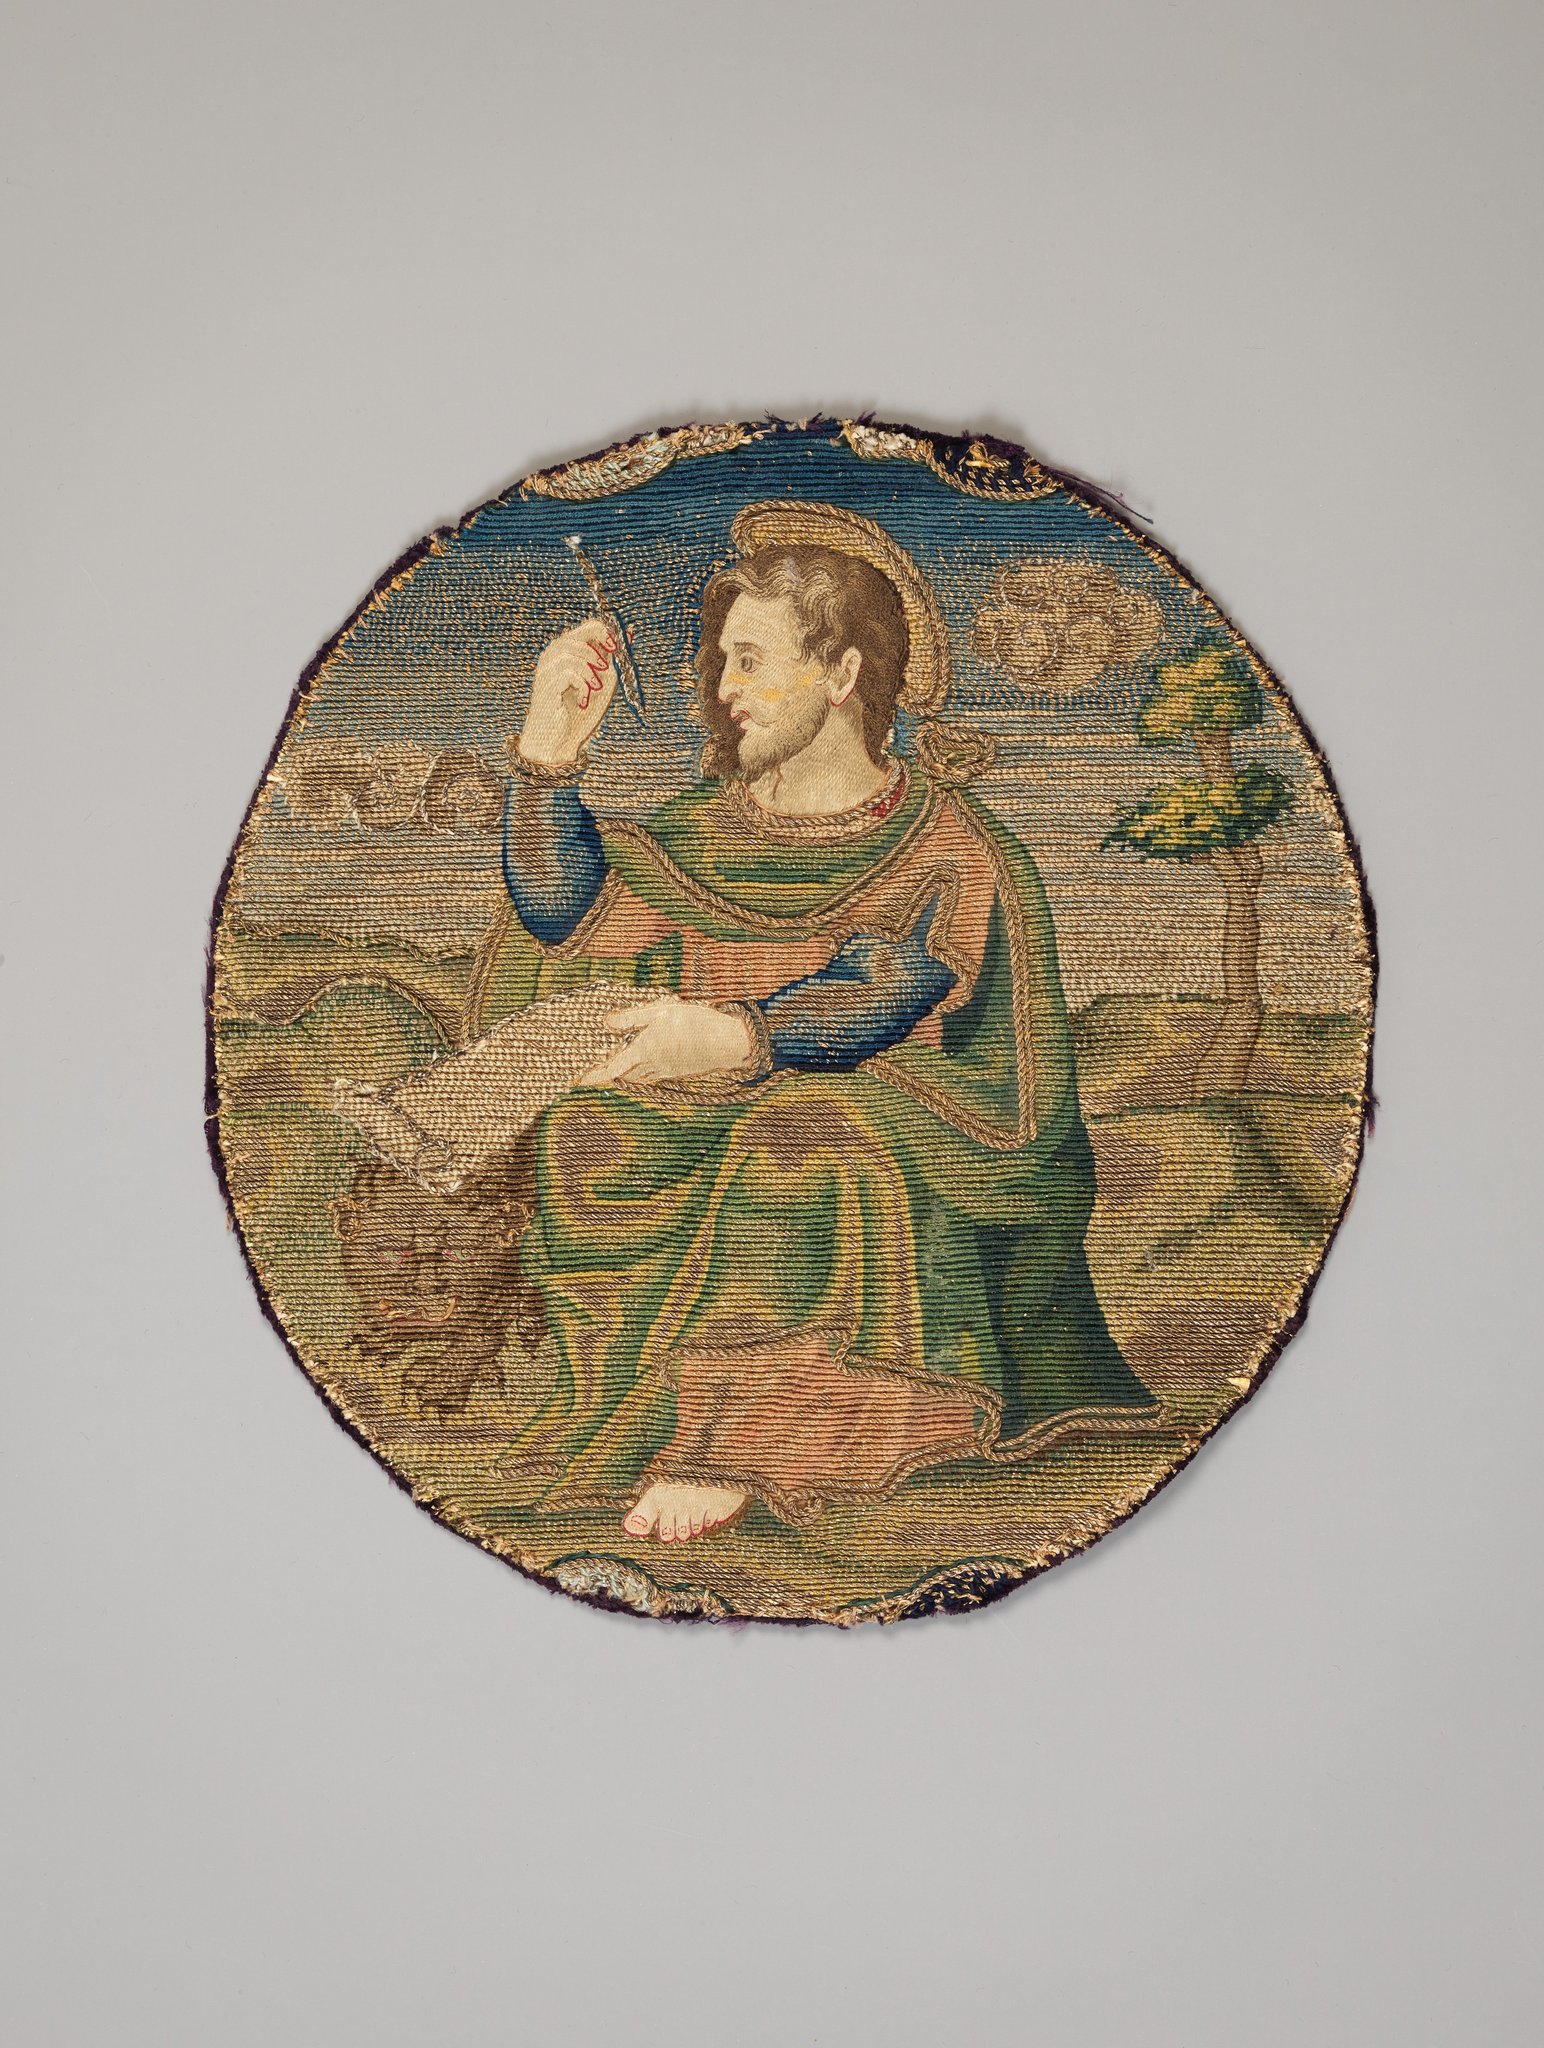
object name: panel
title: Saint Mark (one of four)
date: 1567-1633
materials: canvas, metal thread, silk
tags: trees,saint mark